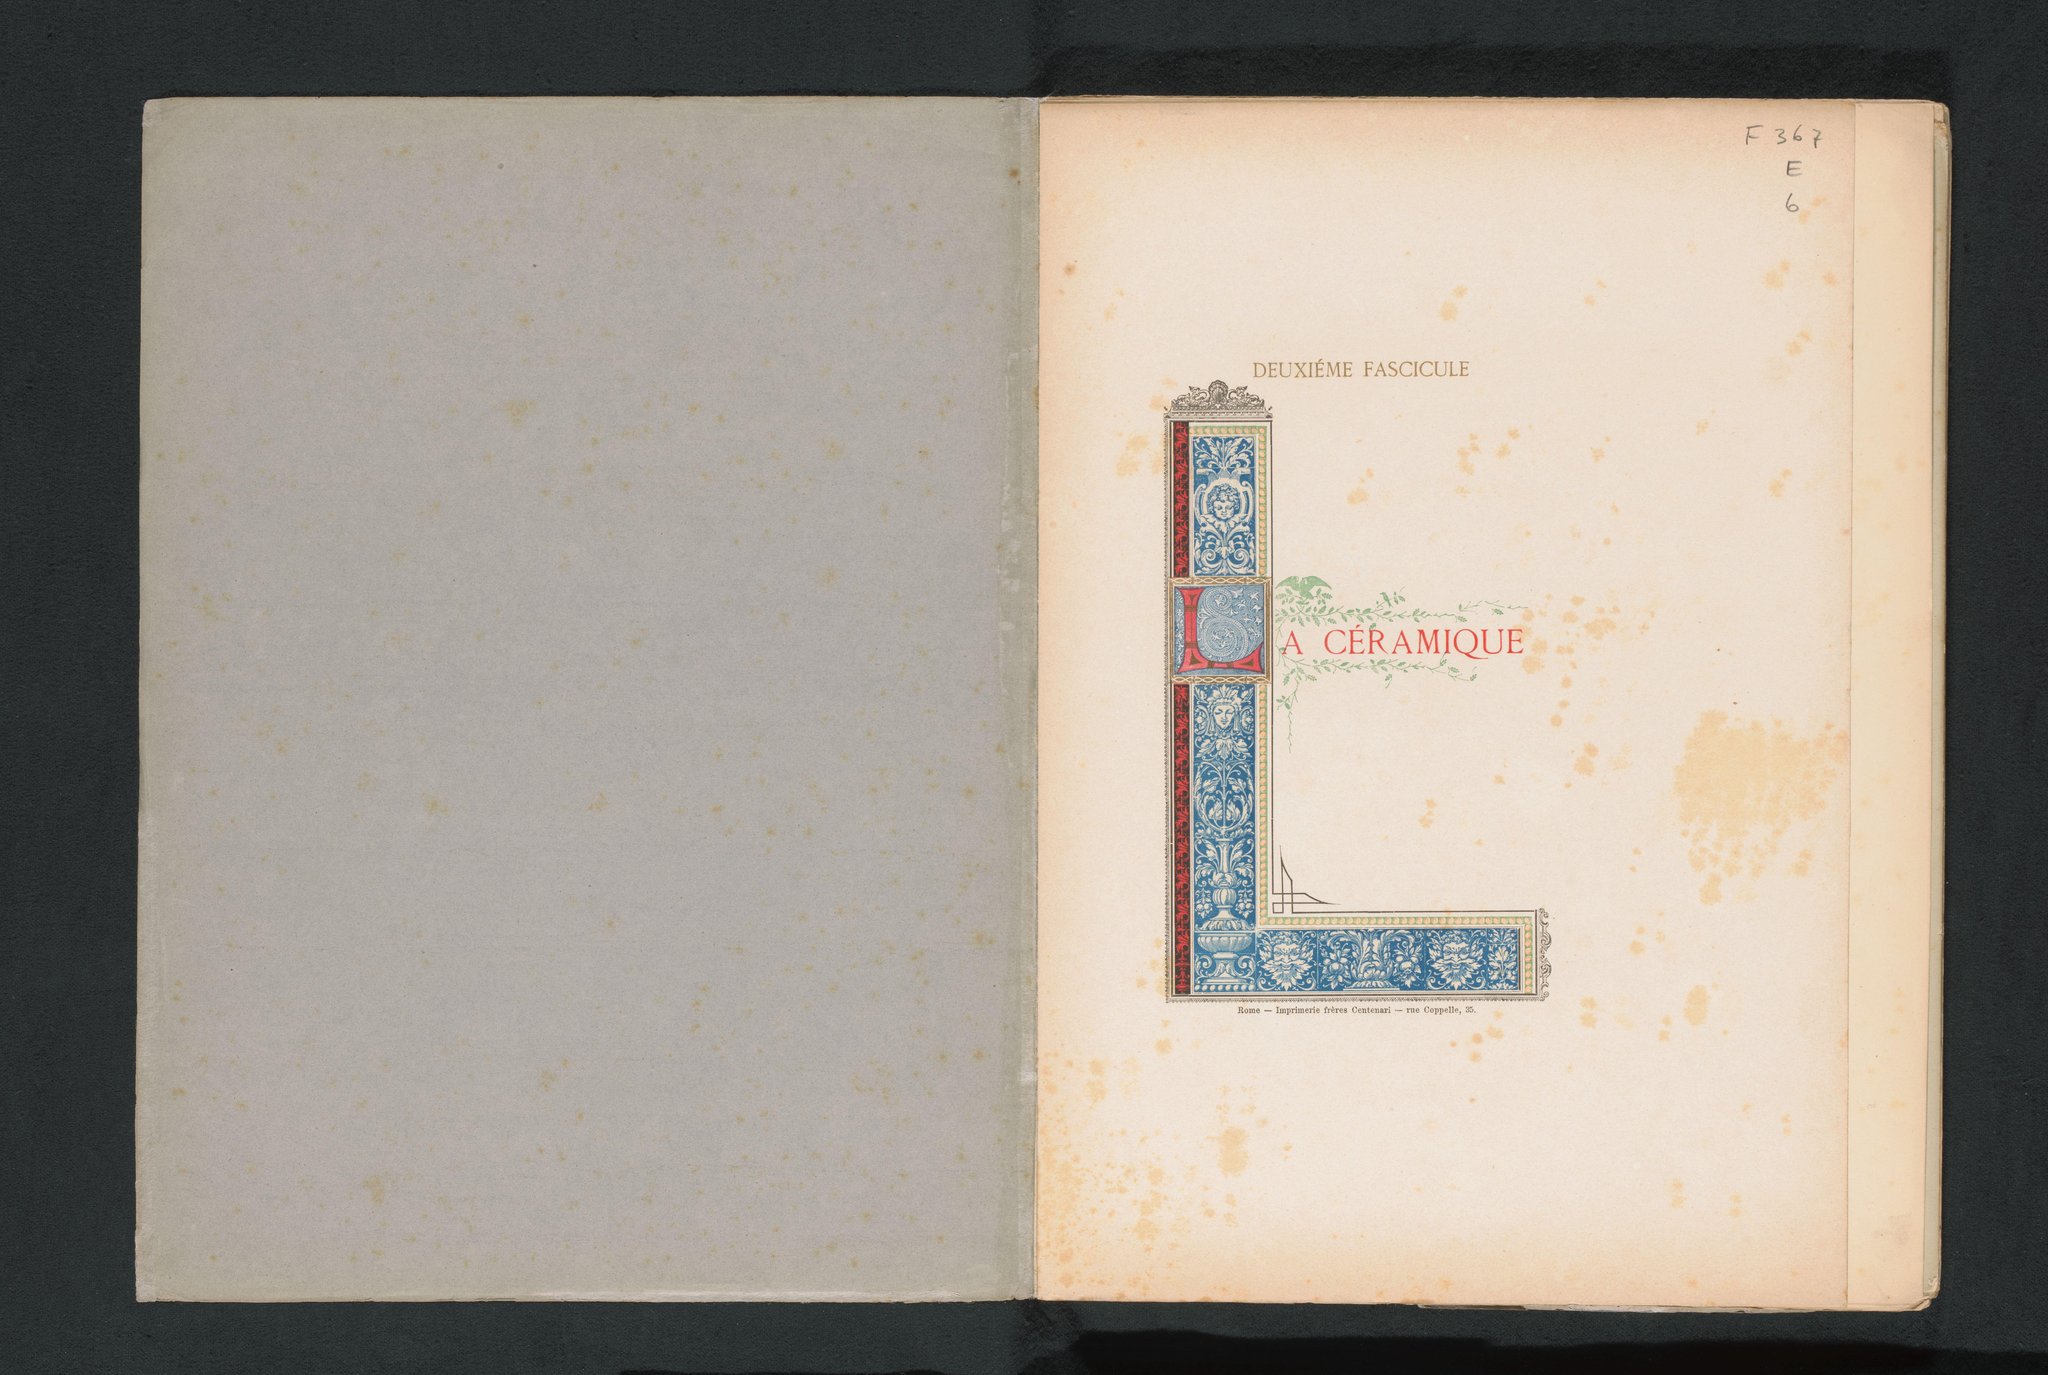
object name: book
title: La section italienne à l'Exposition d'Anvers 1885 / par Théophile Fumière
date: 1885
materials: cardboard, paper, photographic support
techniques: albumen print, printing, engraving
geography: brussels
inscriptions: annotation: ‘D’